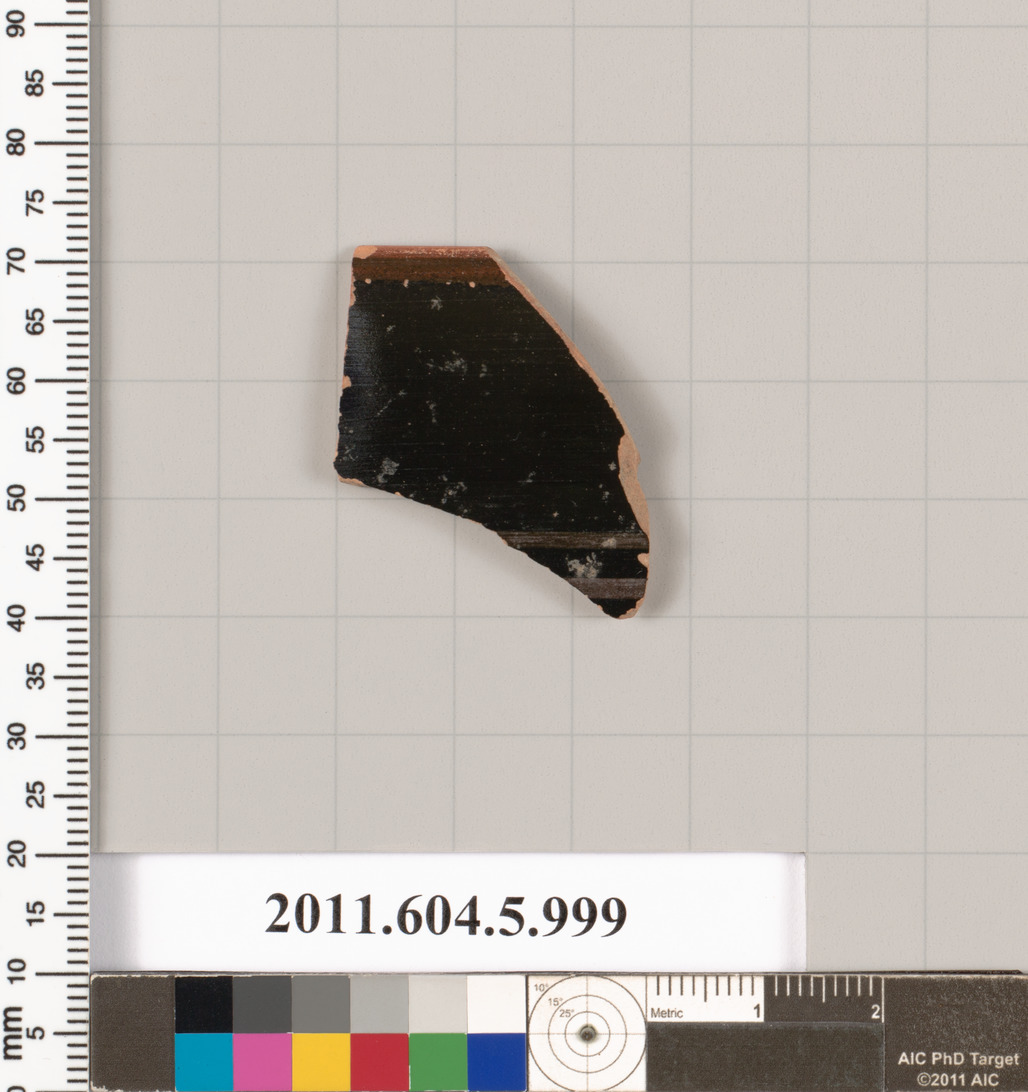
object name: kylix fragment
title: Terracotta rim fragment of a kylix (drinking cup)?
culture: greek, attic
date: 600-401 BCE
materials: terracotta